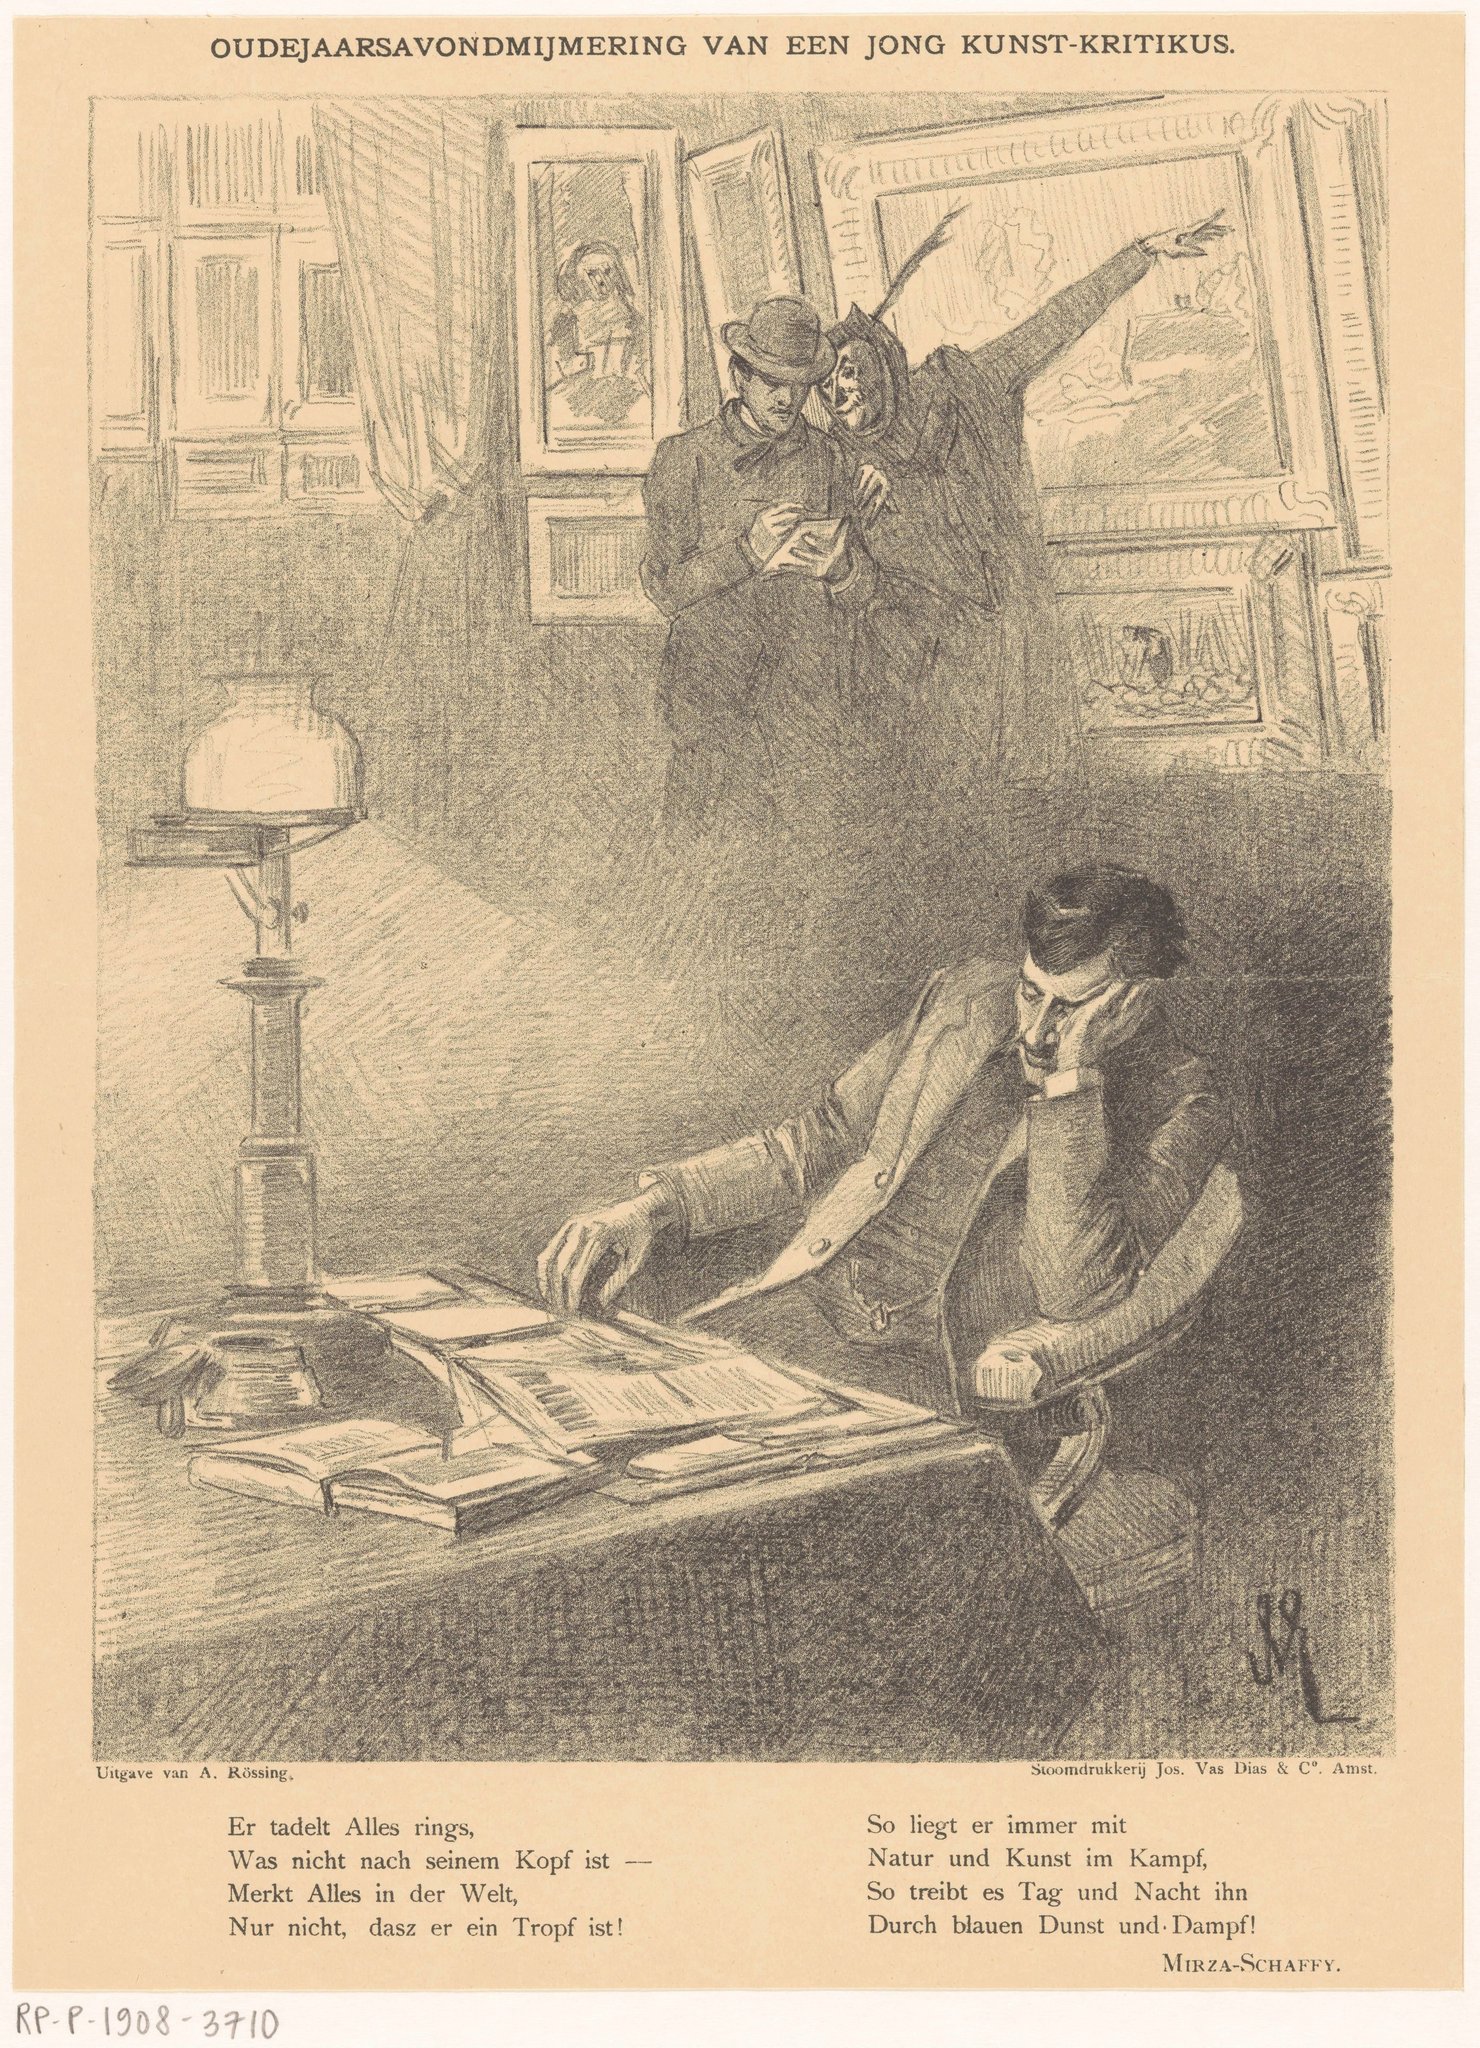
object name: print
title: Oudejaarsavondmijmering van een jong kunst-kritikus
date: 1888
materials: paper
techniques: lithograph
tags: criticizing and discussing art, art criticism, contemplation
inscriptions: collector's mark: Lugt 2228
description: Een man gezeten aan een leestafel. Zijn hoofd leunt op zijn hand. Op de achtergrond twee mannen die samen schilderijen bekijken. Eén van hen maakt aantekeningen op een vel papier. Onder het geheel een tekst van de Azerbeidzjaanse dichter Mirza Schaffy.